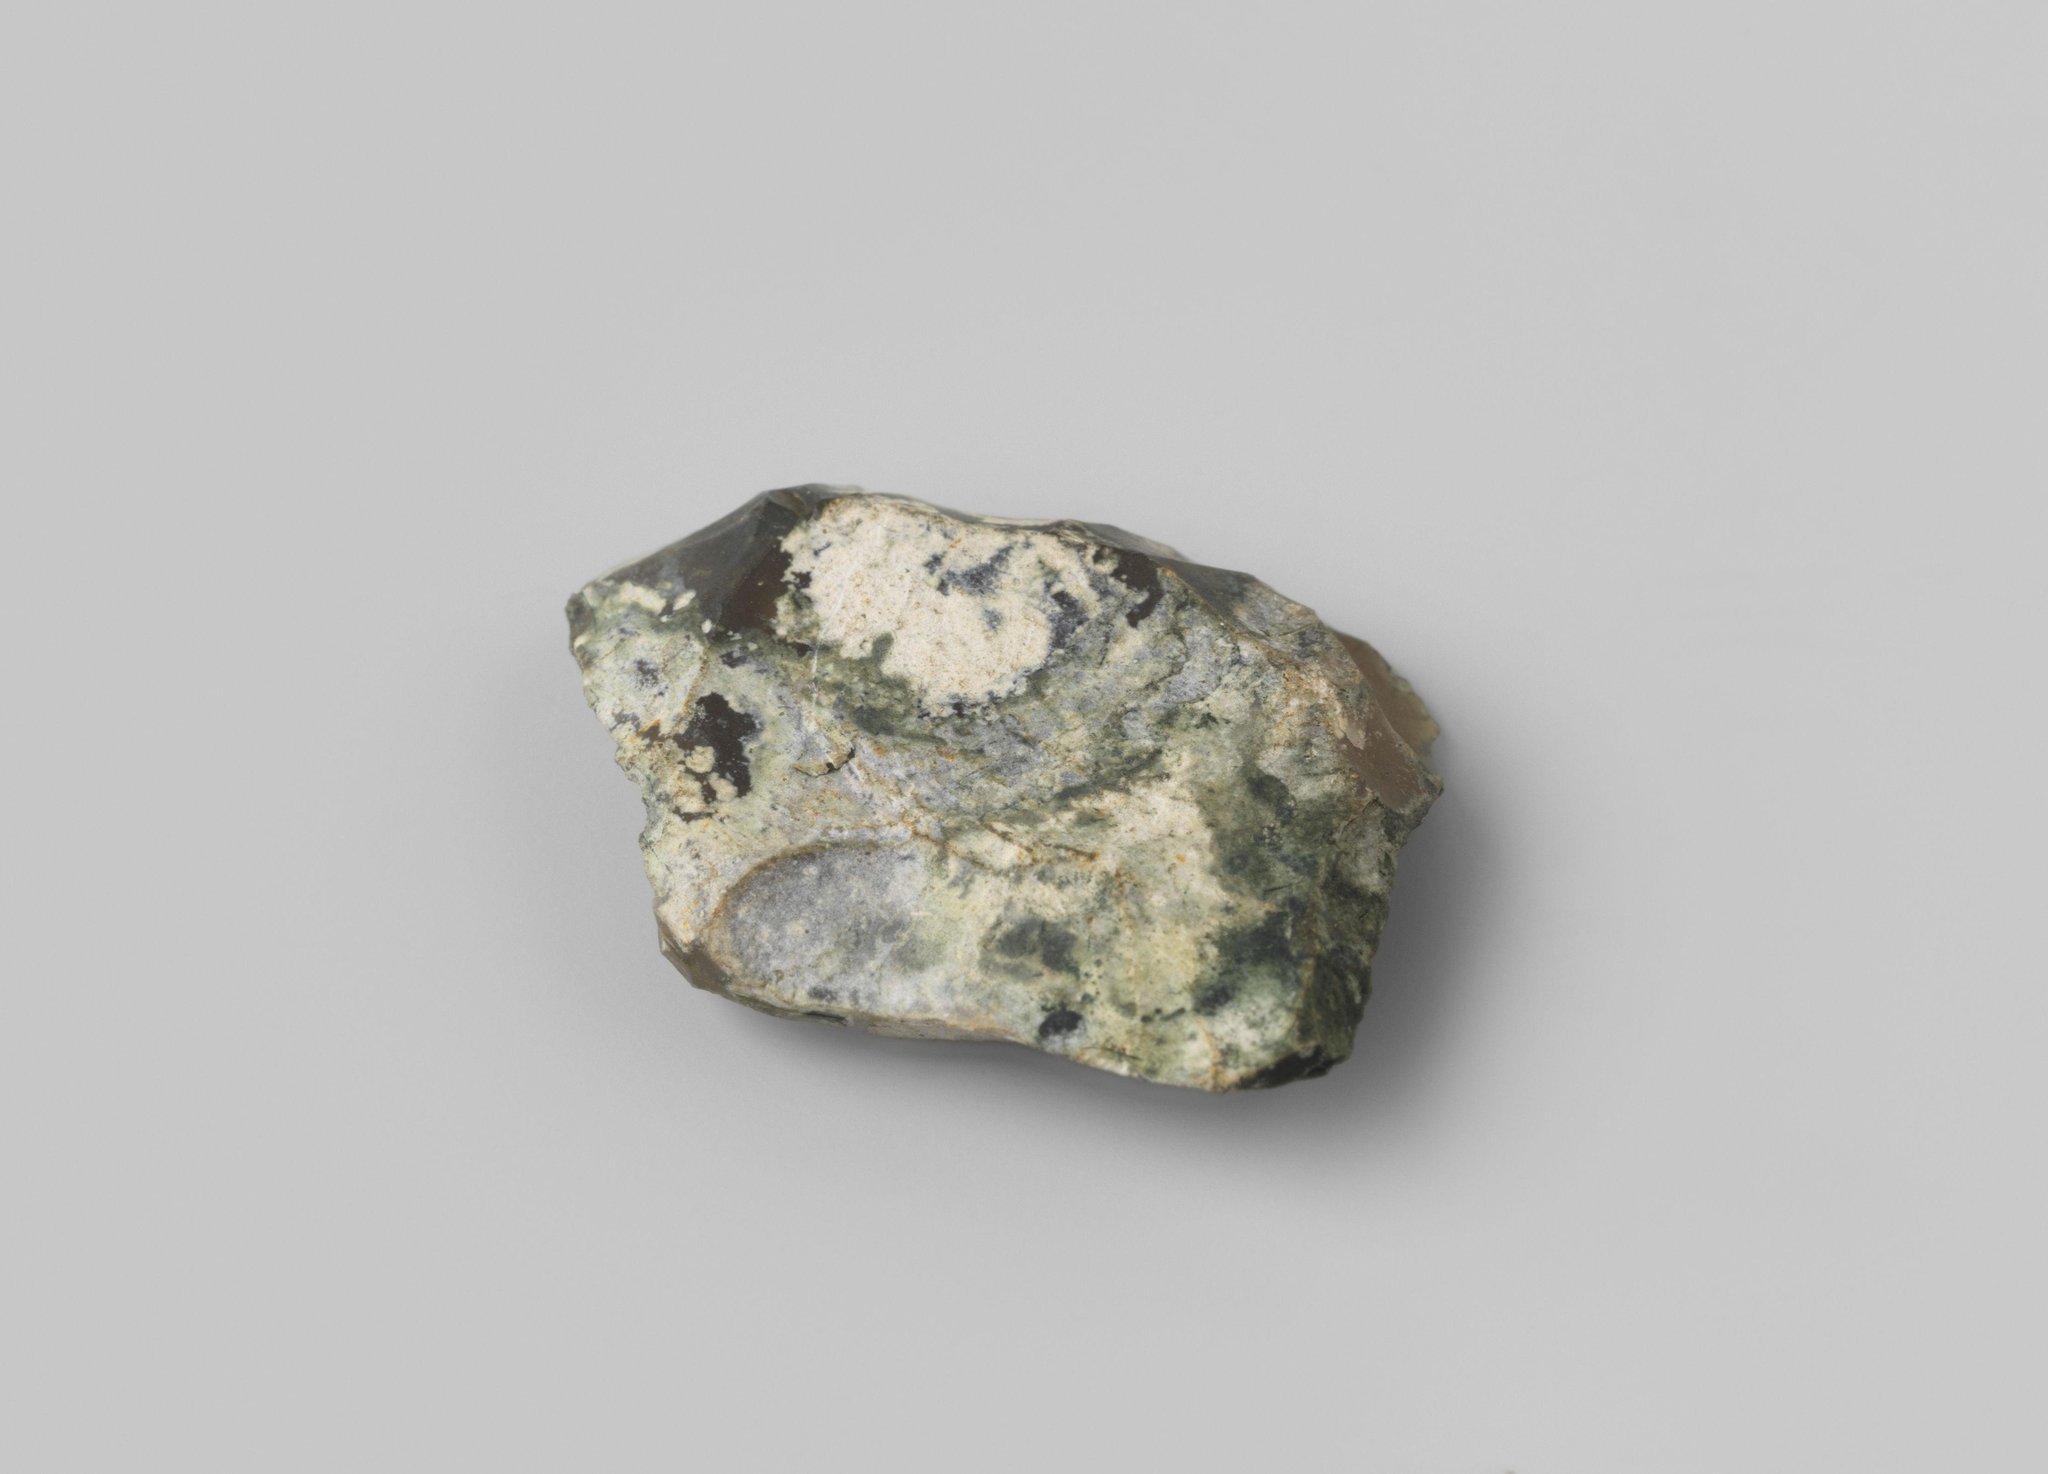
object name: gunflint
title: Vuursteen van een handwapen uit het wrak van de Oost-Indiëvaarder Hollandia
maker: Anonymous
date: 1700-1743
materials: stone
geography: netherlands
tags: verenigde oostindische compagnie, hollandia (schip), annet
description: Hand weapon, flint; sim. NG 1980-27H3128, eroded.